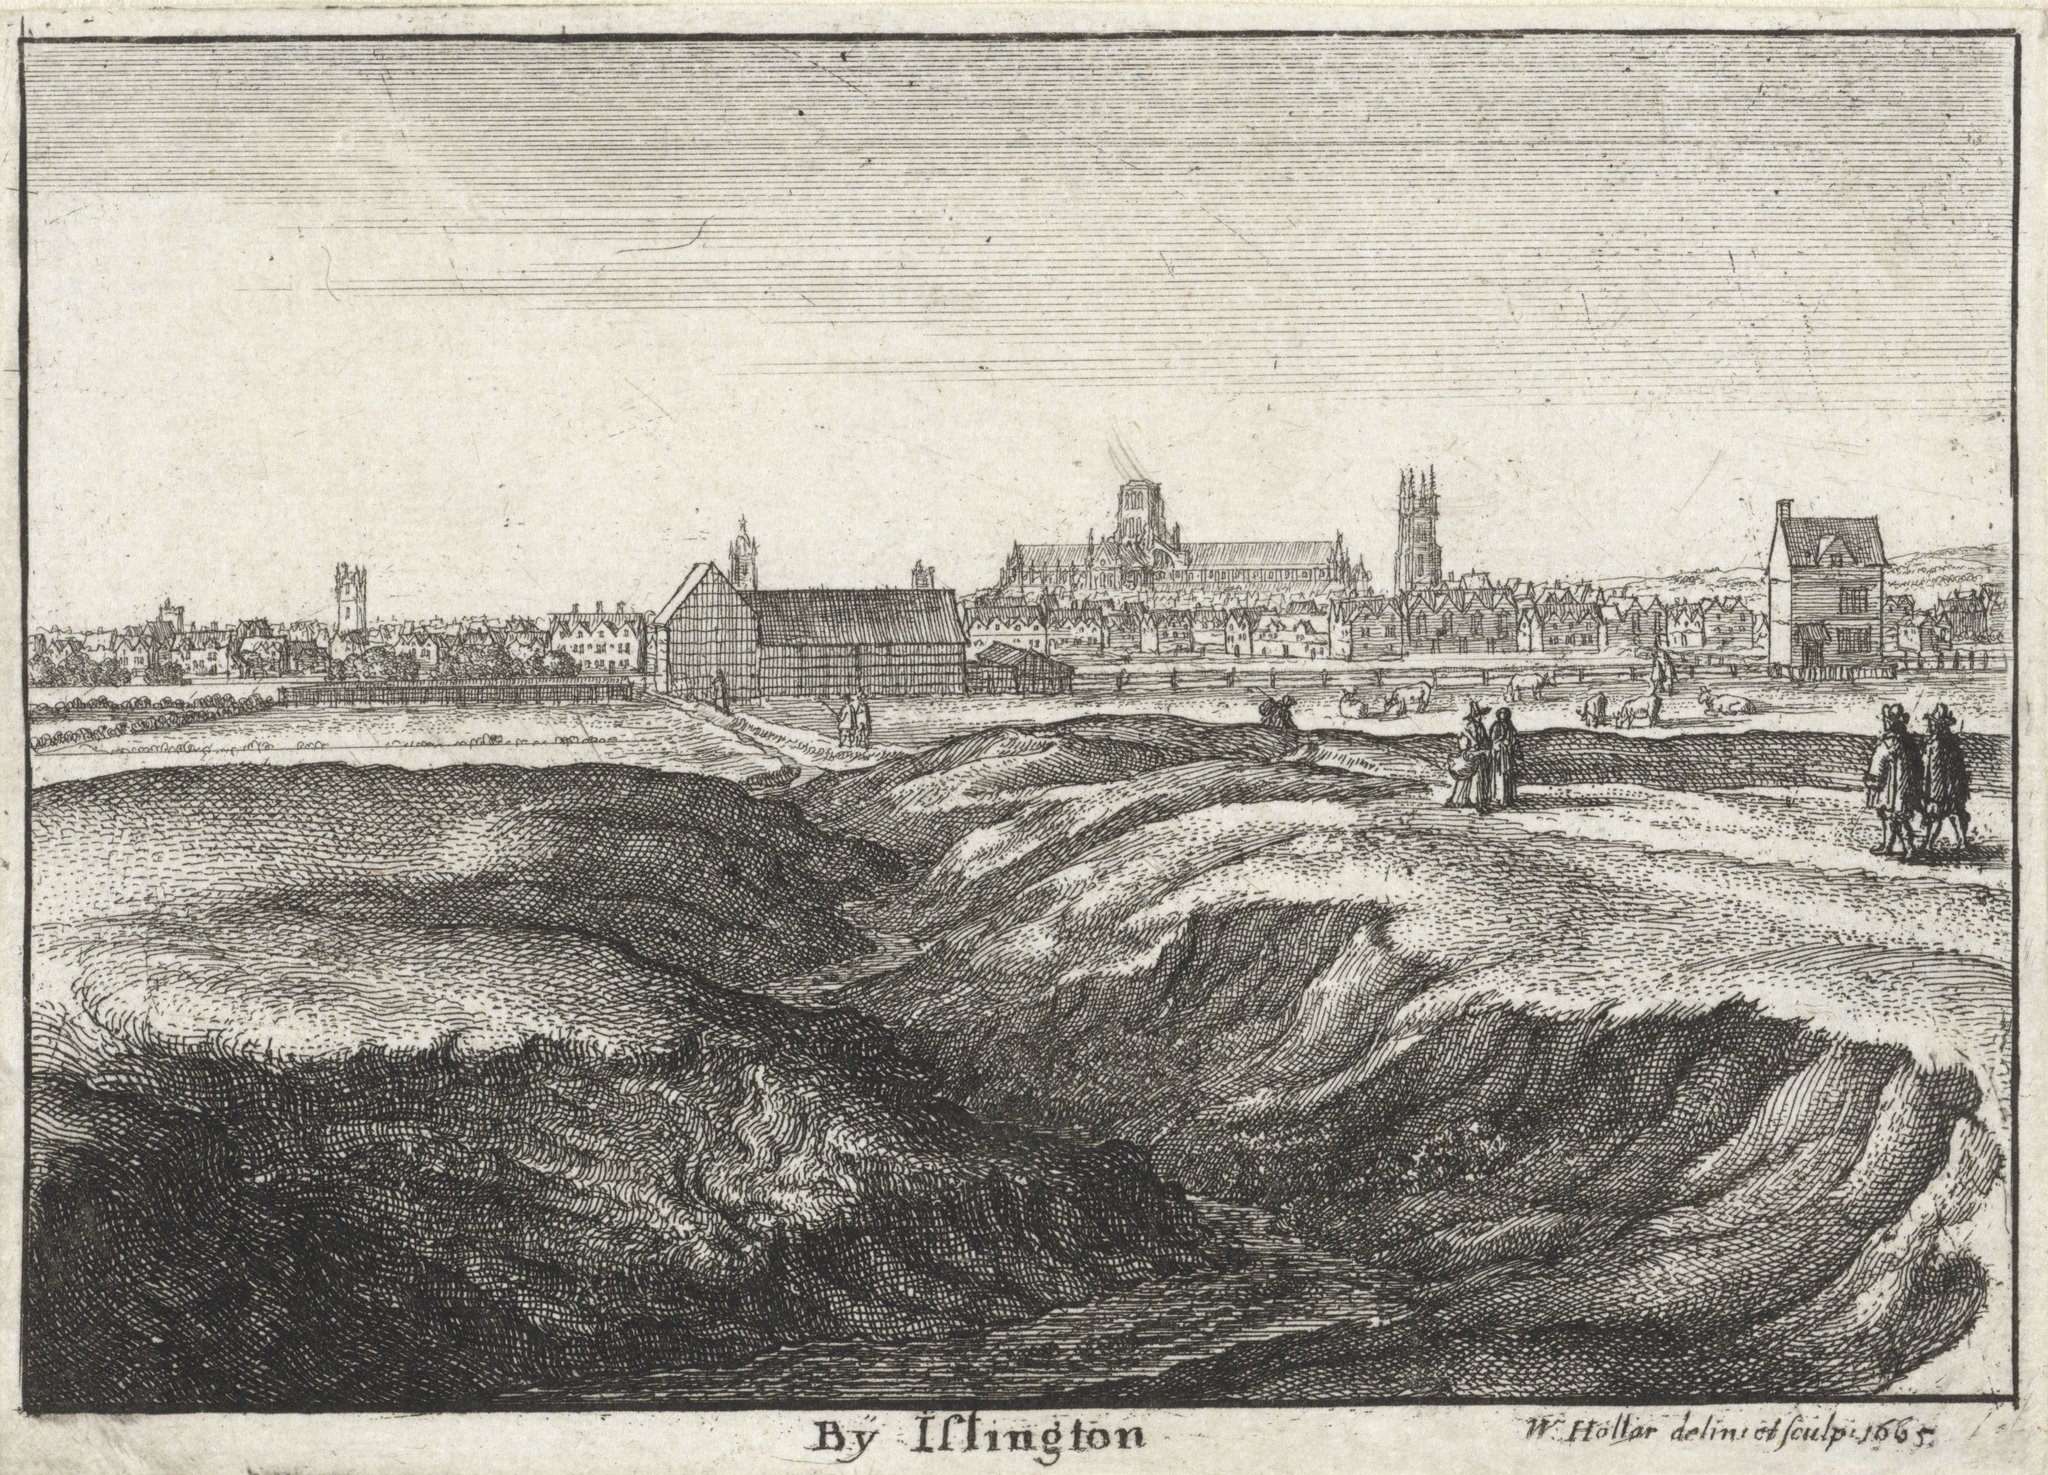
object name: print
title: Gezicht op Islington (Londen) met greppel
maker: wenceslaus hollar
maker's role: draughtsman, print maker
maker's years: 1607-1677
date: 1665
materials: paper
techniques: etching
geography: london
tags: city-view, and landscape with man-made constructions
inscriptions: collector's mark: Lugt 240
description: De prent maakt deel uit van een zesdelige serie met gezichten nabij Londen.